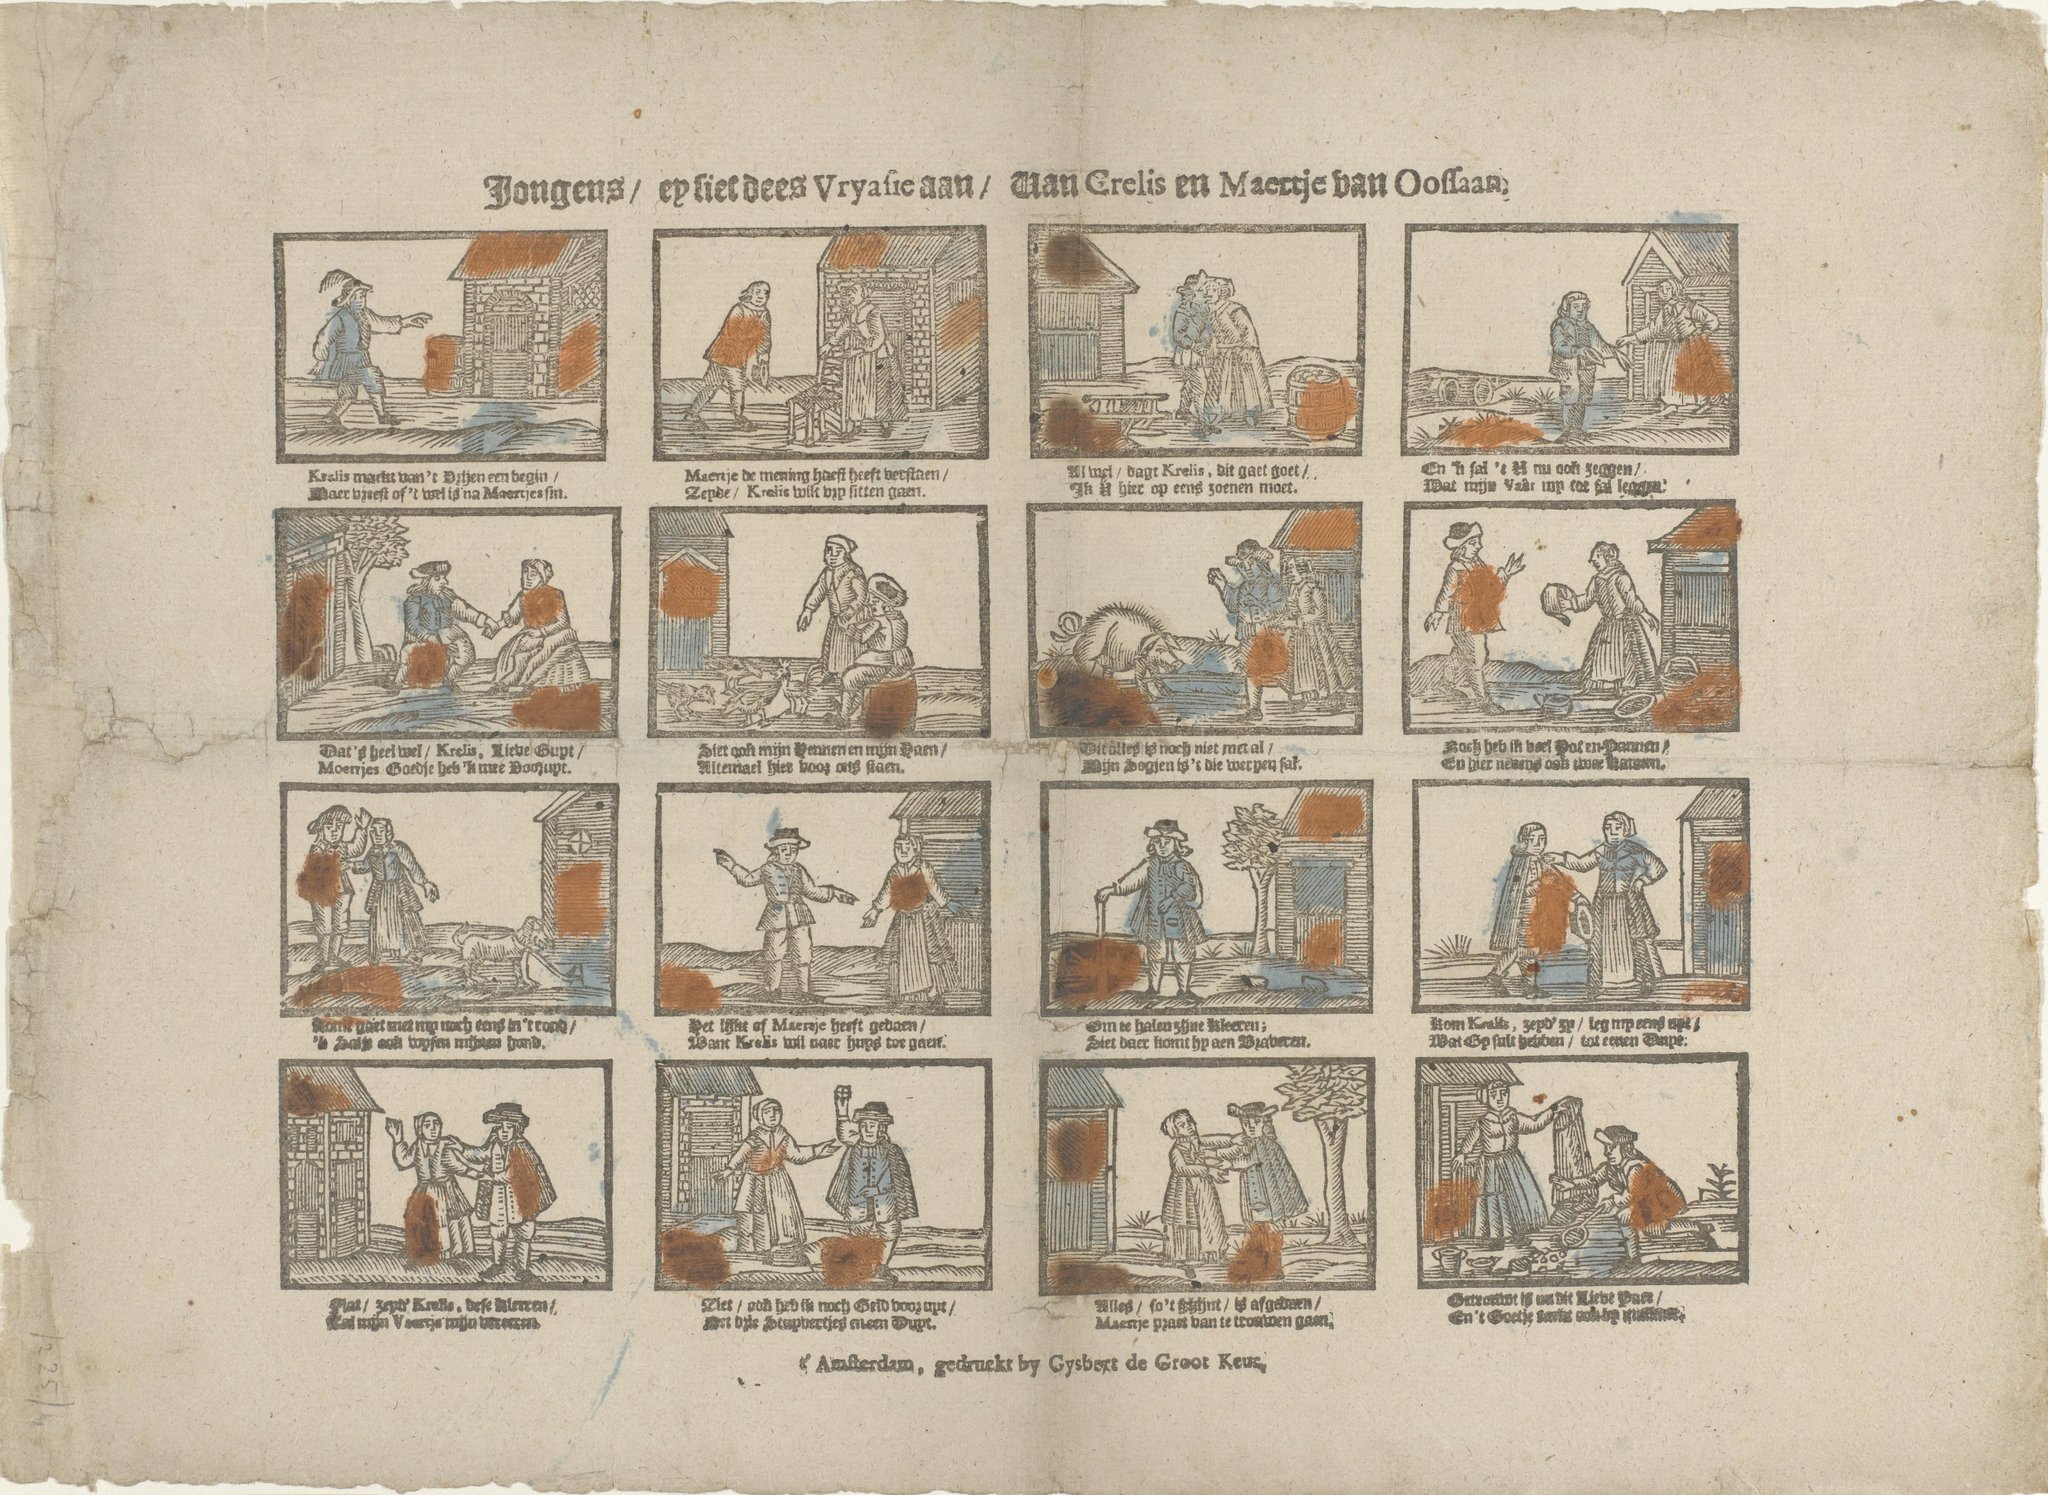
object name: popular print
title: Jongens/ey siet dees Vryasie aan / van Crelis en Maertje van Ossaan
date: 1738-1767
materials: paper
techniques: colour, letterpress printing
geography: amsterdam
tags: courting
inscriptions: collector's mark: Lugt 2228, collector's mark: Lugt 2760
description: Blad met 16 voorstellingen van de vrijage van de arme Krelis en Maartje van Oostzaan. Onder elke afbeelding een tweeregelig vers.